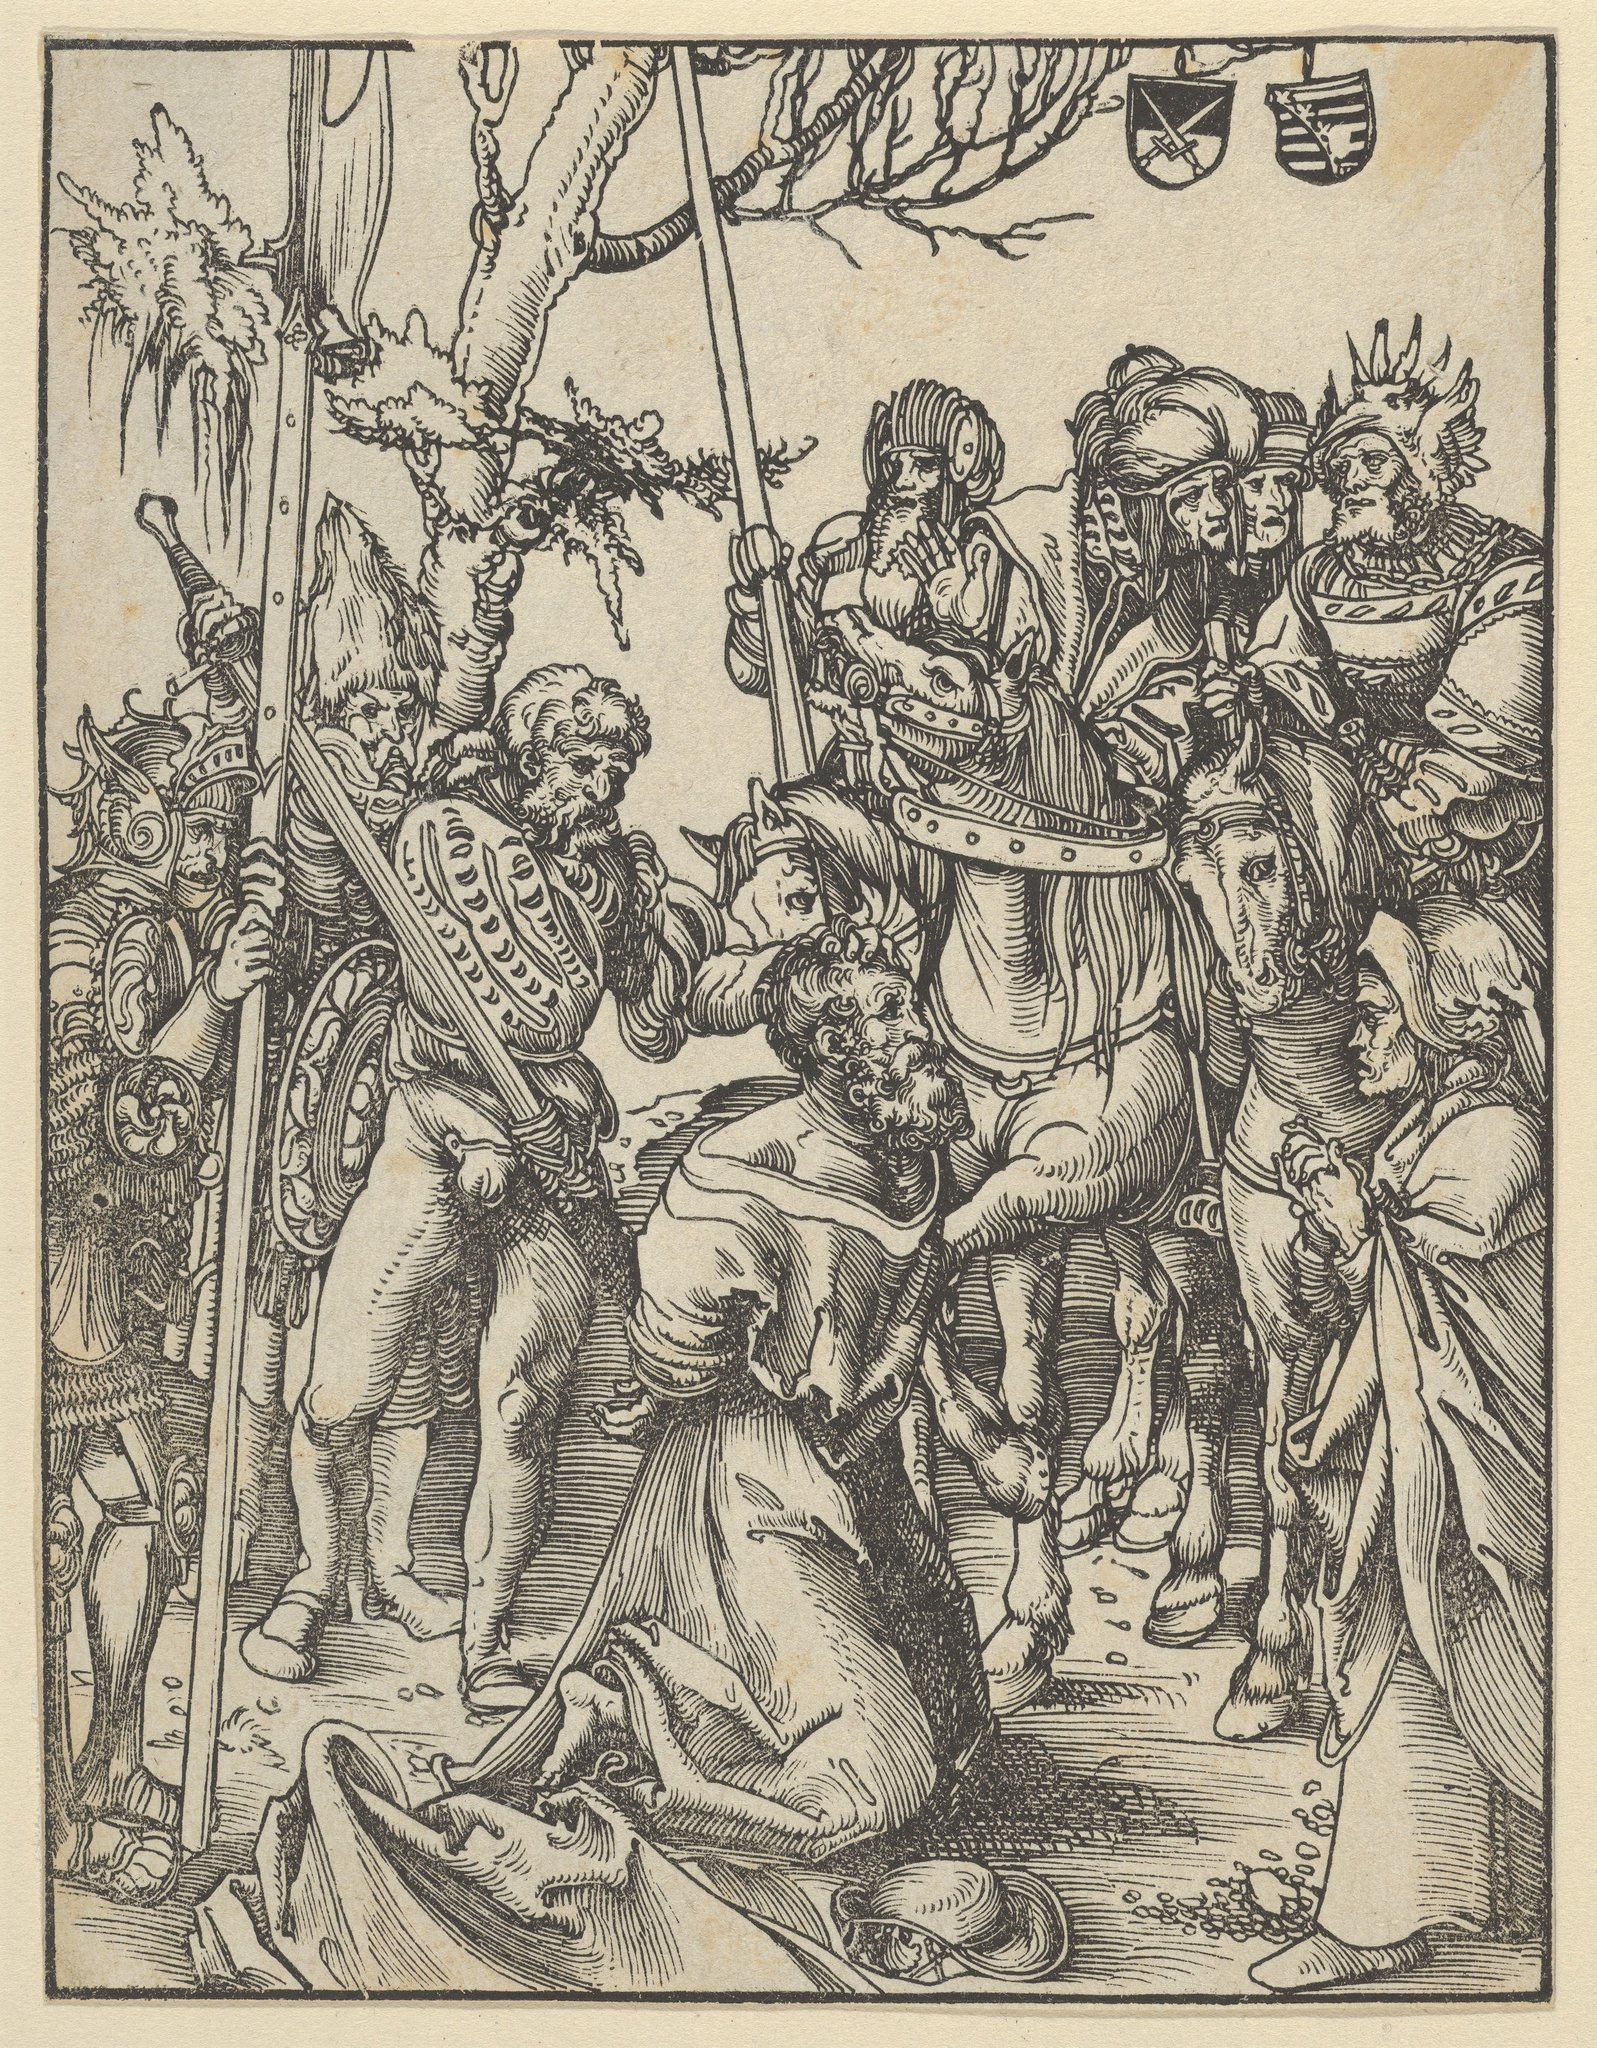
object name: print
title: James The Greater from the Martyrdom of the Twelve Apostles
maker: lucas cranach the elder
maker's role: artist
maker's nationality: german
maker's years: 1472-1553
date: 1472-1553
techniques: woodcut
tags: soldiers,suffering,men,horses,apostles